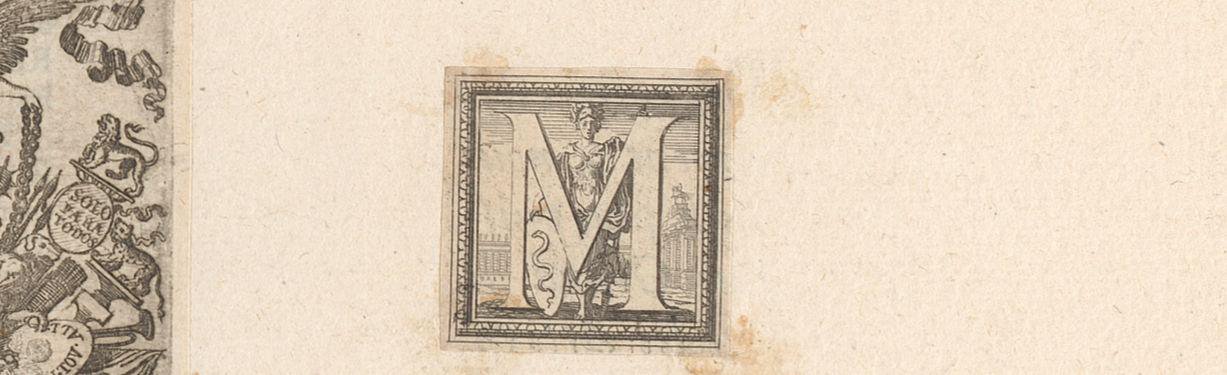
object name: print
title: Initiaal 'M' met Minerva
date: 1676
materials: paper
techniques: etching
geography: paris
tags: (story of) minerva (pallas, athena), initial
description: Prent uit: Félibien, André. Des principes de l'architecture (...). Parijs: Jean-Baptiste (I) Coignard, 1676.